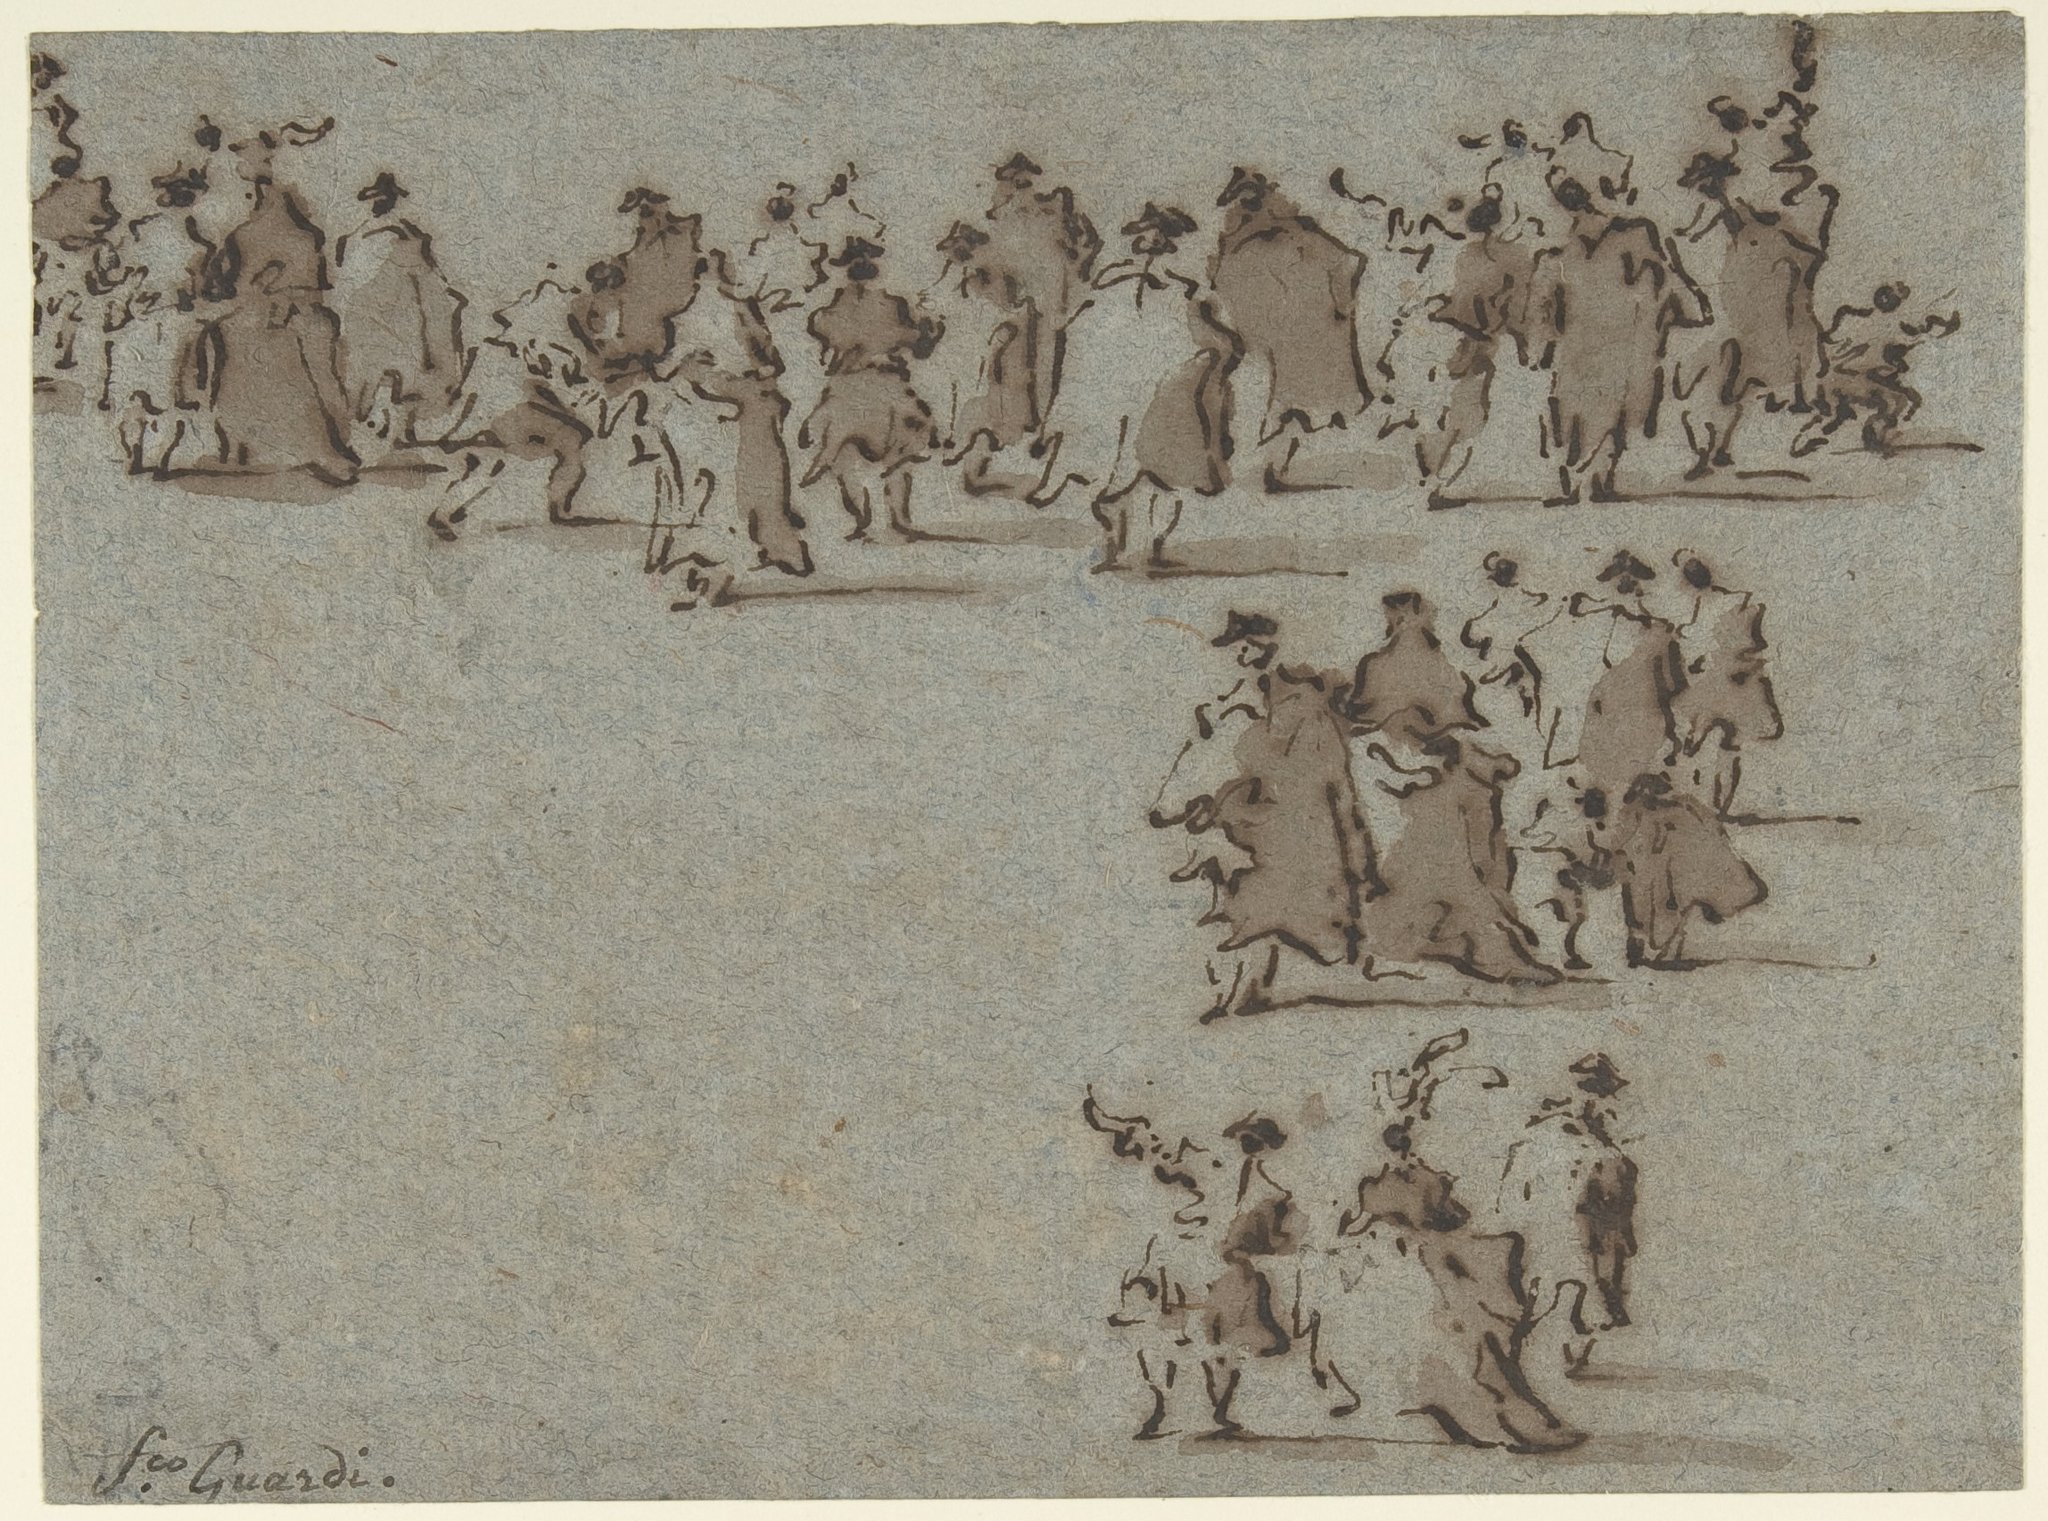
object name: drawing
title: Studies of Walking Figures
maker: francesco guardi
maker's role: artist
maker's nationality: italian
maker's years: 1712-1793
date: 1712-1793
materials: chalk, ink, paper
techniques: brush, drawing, pen, wash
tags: human figures,walking